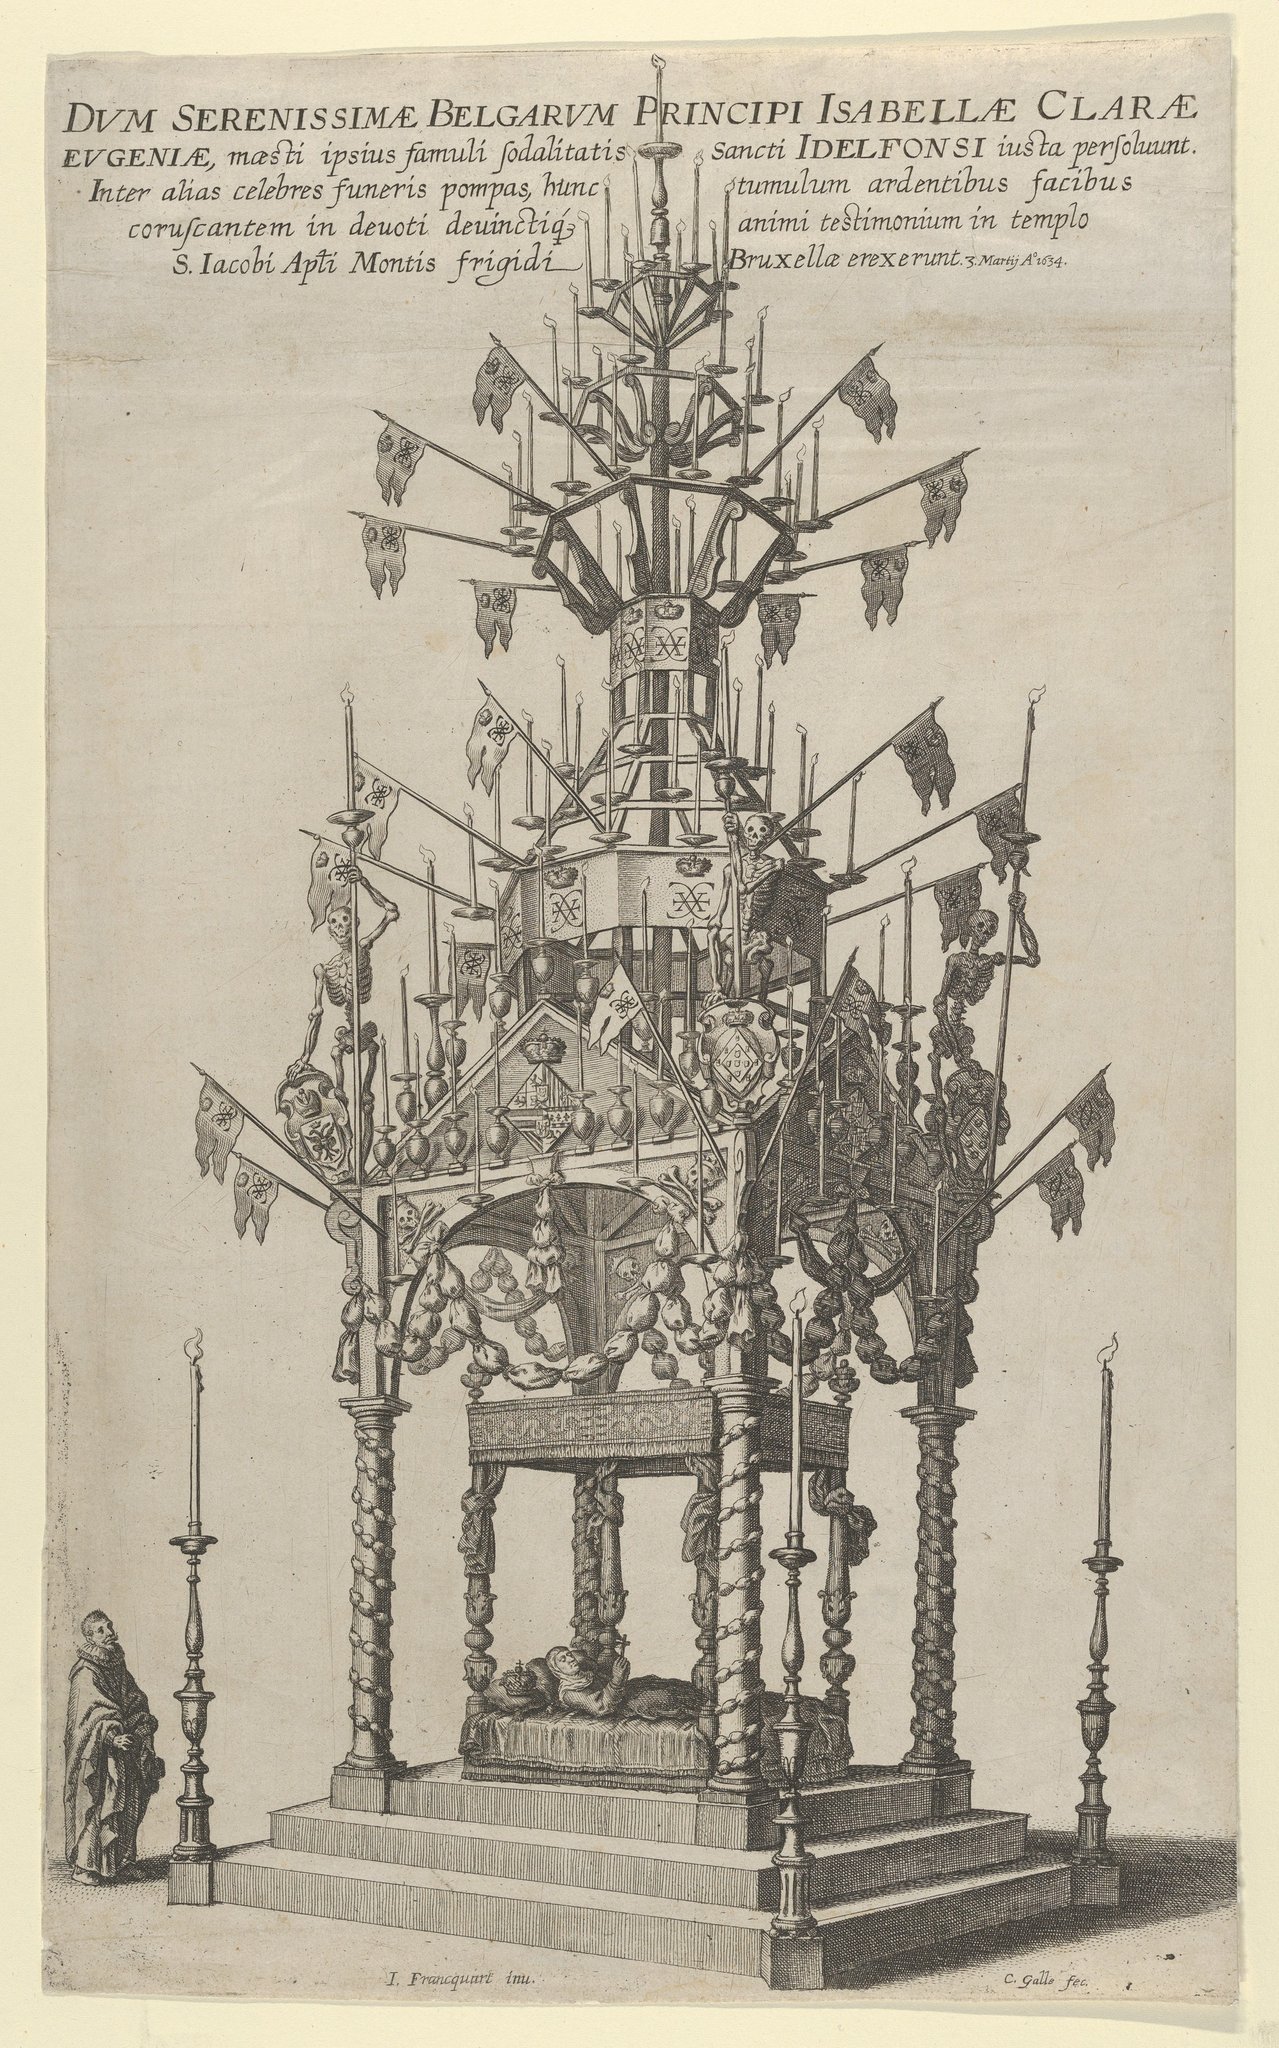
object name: print, fete, ornament architecture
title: Catafalque for Isabella Clara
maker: cornelis galle (i)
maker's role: artist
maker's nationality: netherlandish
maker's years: 1576-1650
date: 1634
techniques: etching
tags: human figures,architecture,flags